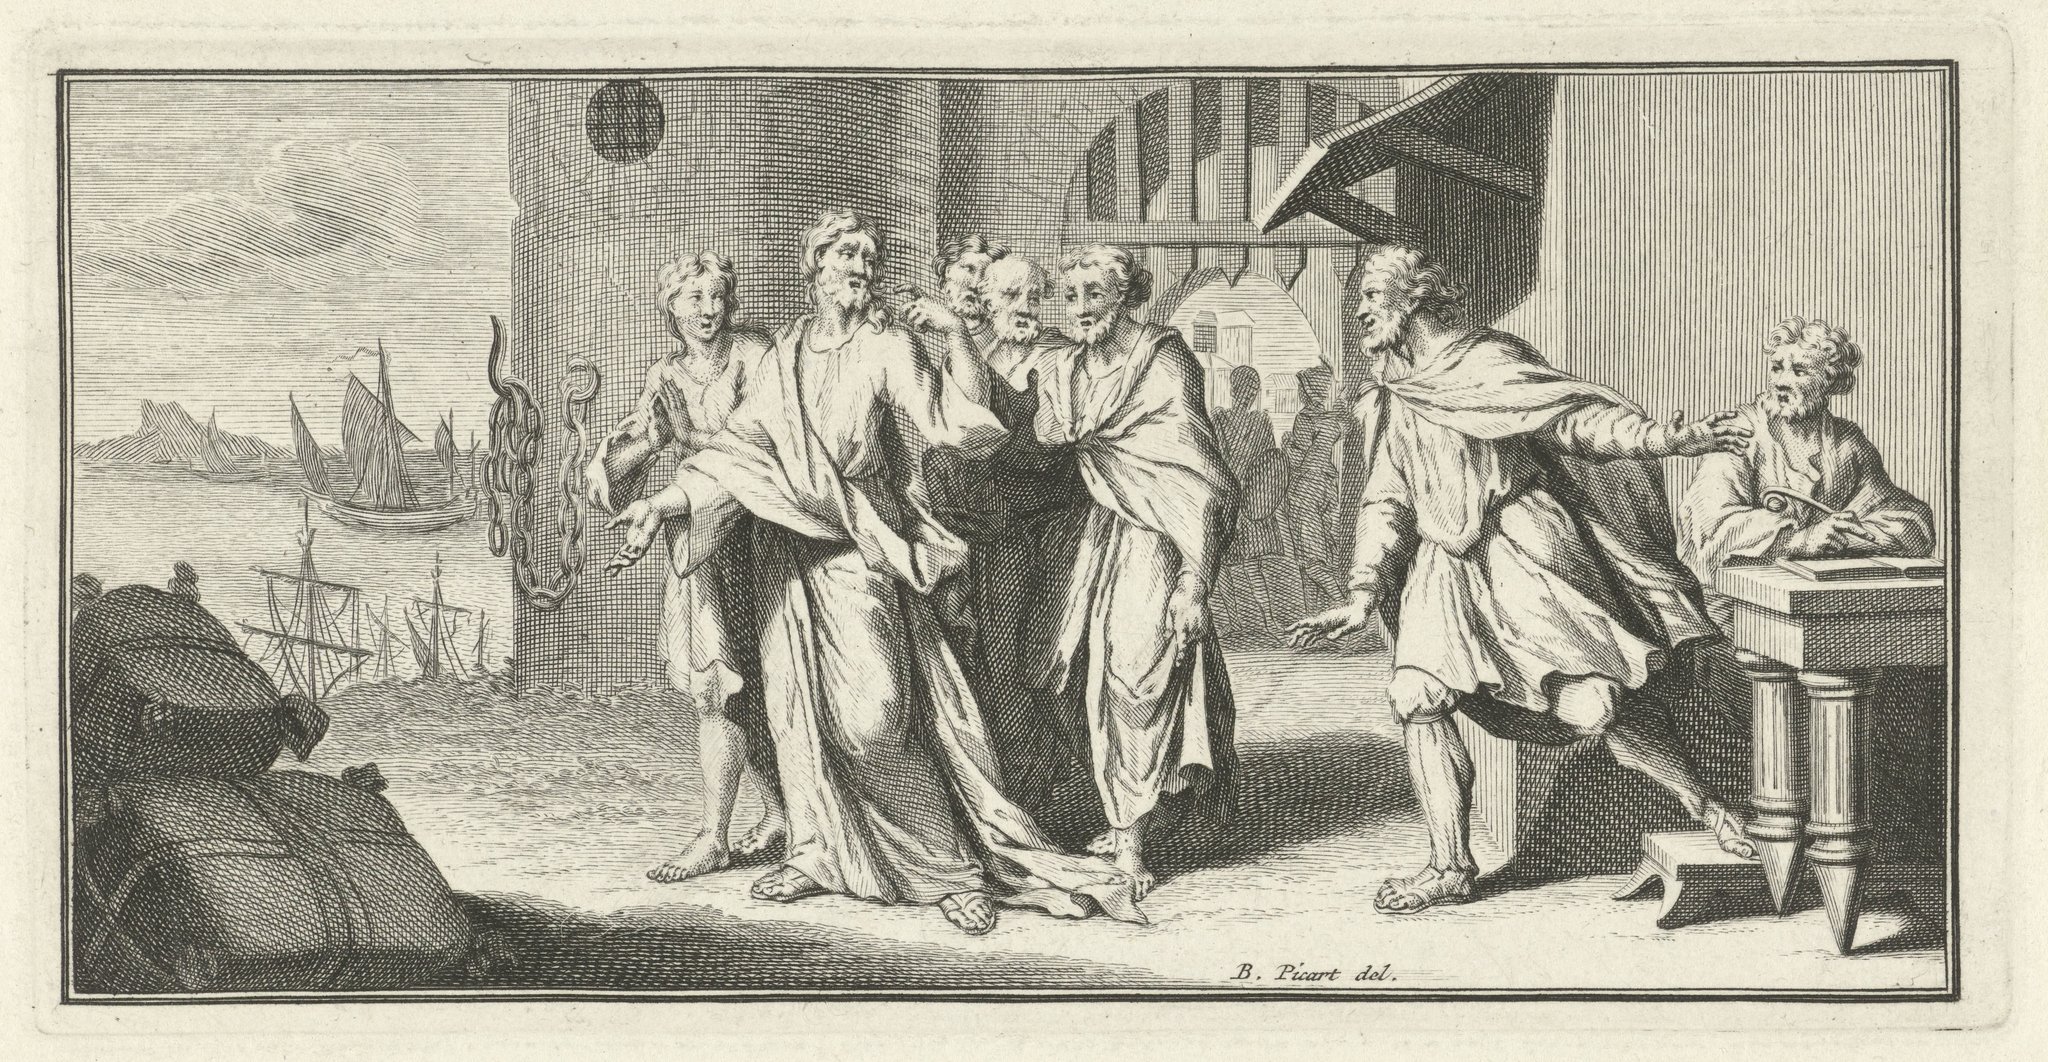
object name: print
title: Opdracht van Christus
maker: bernard picart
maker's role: draughtsman, print maker, publisher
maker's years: 1673-1733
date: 1683-1733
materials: paper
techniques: engraving, etching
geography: amsterdam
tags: adult christ together with apostles, evangelists, saints, etc.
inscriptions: collector's mark: Lugt 2233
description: Christus te midden van enkele apostelen geeft een opdracht aan een man.